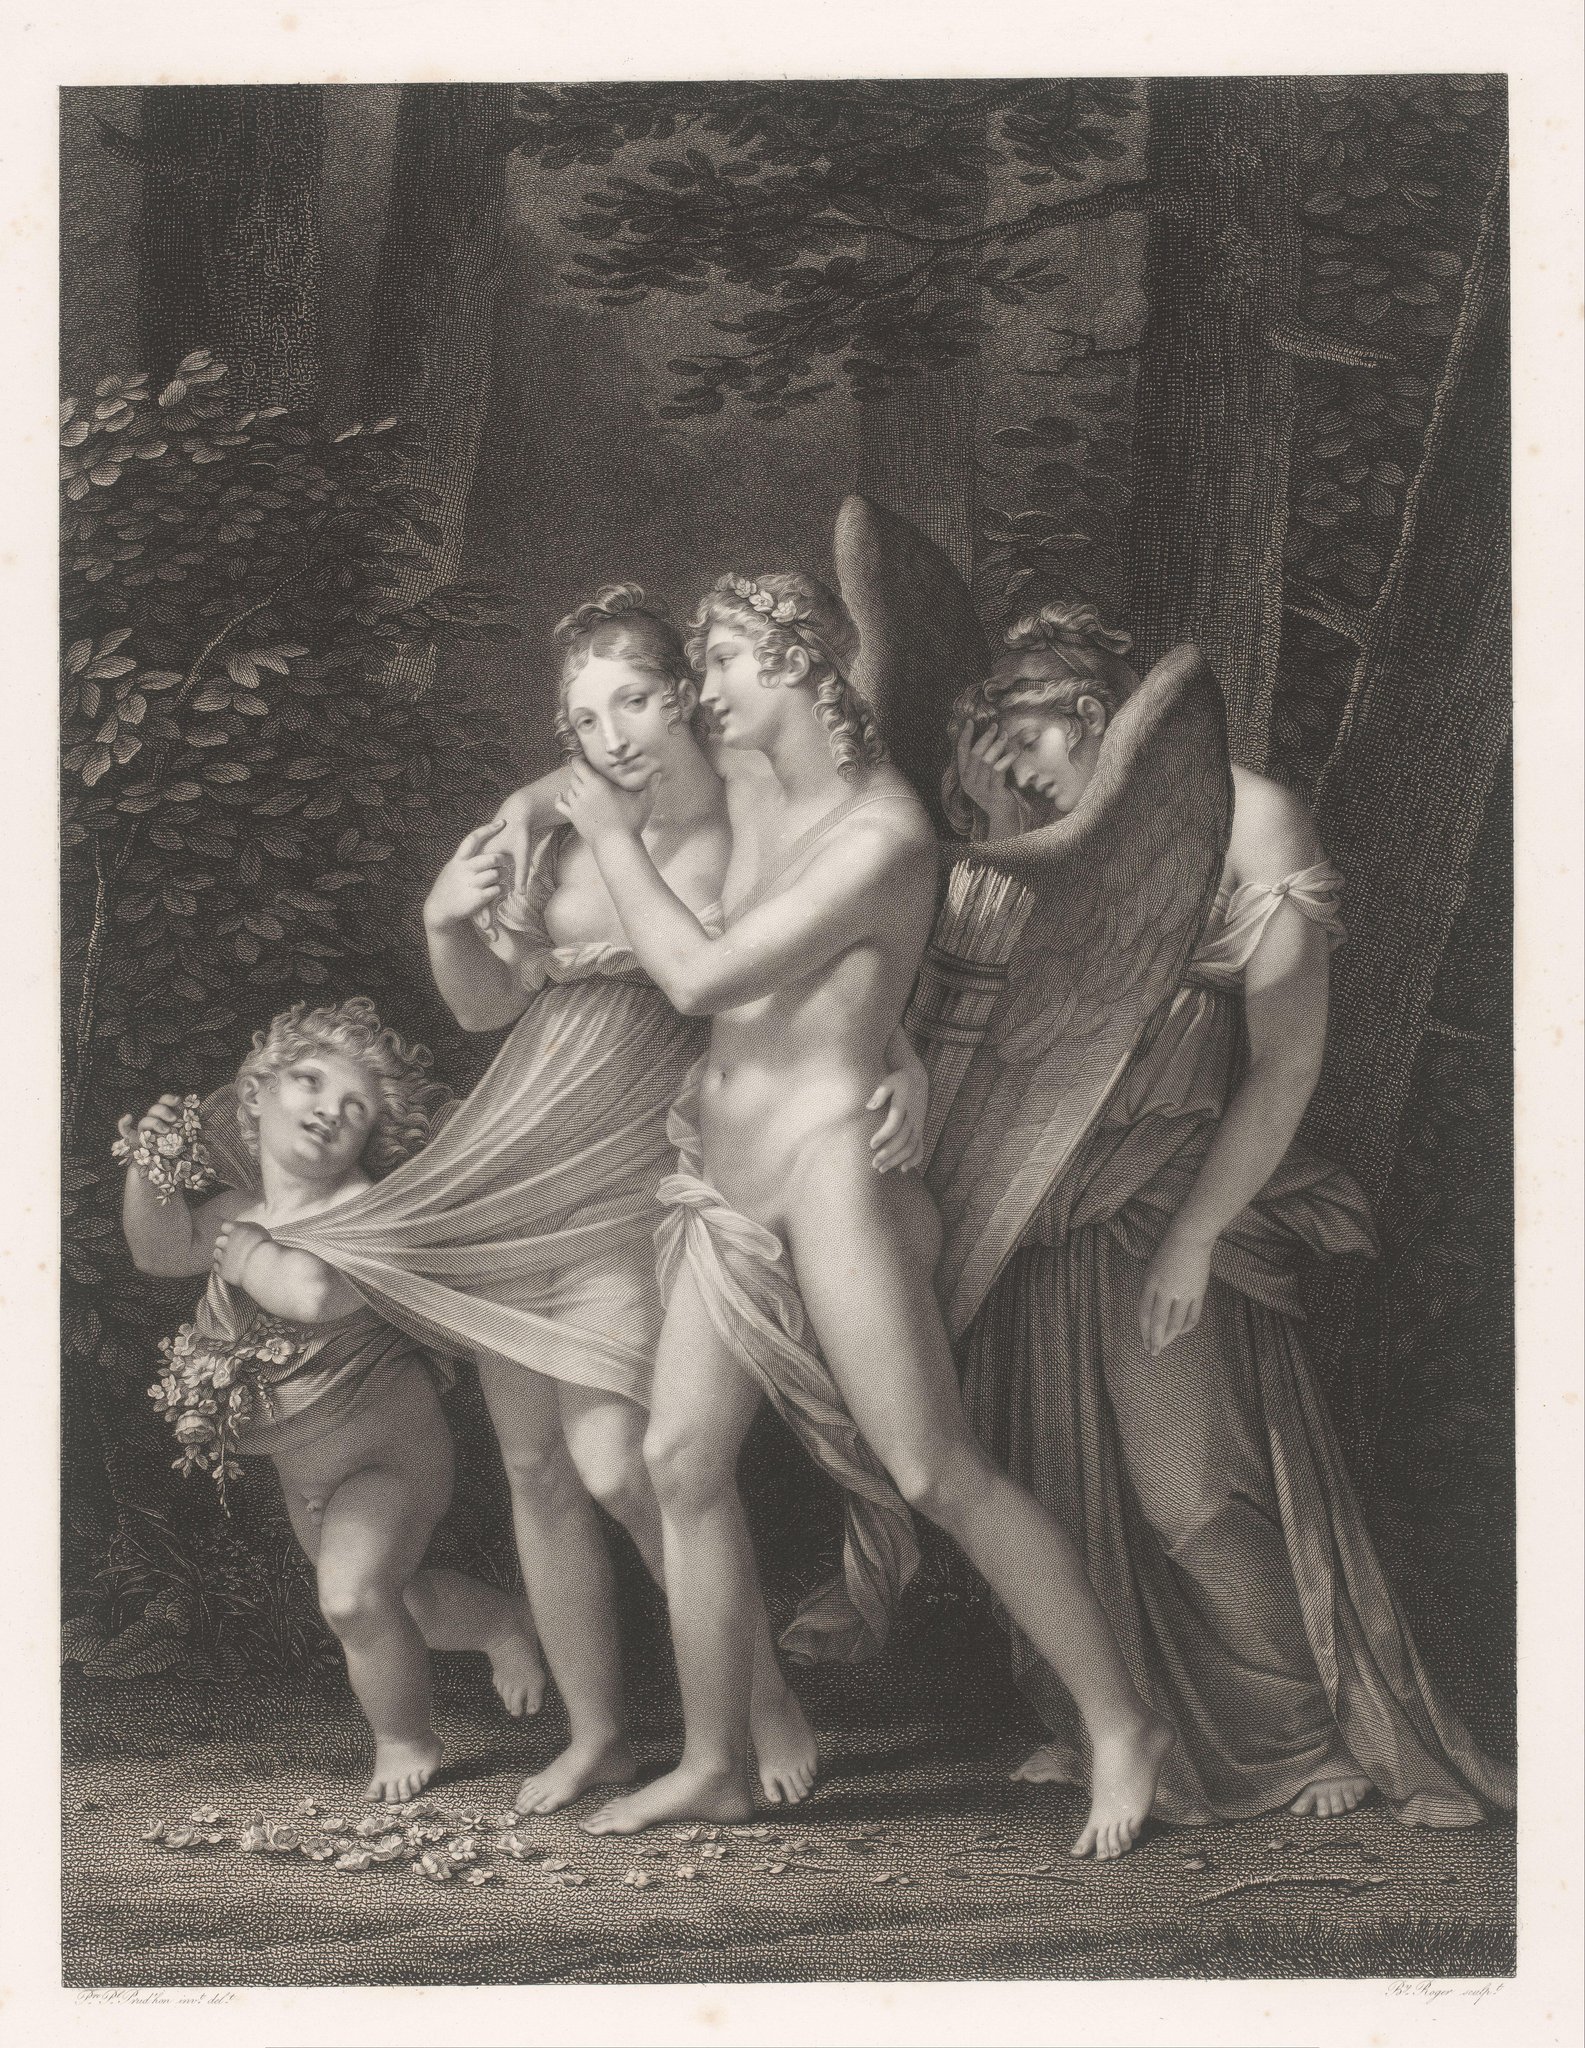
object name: print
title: Amor verleidt Onschuld tot Plezier met Berouw als gevolg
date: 1812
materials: paper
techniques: etching, roulette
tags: pleasure, enjoyment, joy; 'allegrezza', 'allegrezza da le medaglie', 'allegrezza, letitia e giubilo', 'diletto', 'piacere', 'piacere honesto' (ripa), innocence; 'innocenza', 'innocenza o purità' (ripa), (story of) cupid, amor (eros), regret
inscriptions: collector's mark: Lugt 2228, collector's mark: Lugt 2760